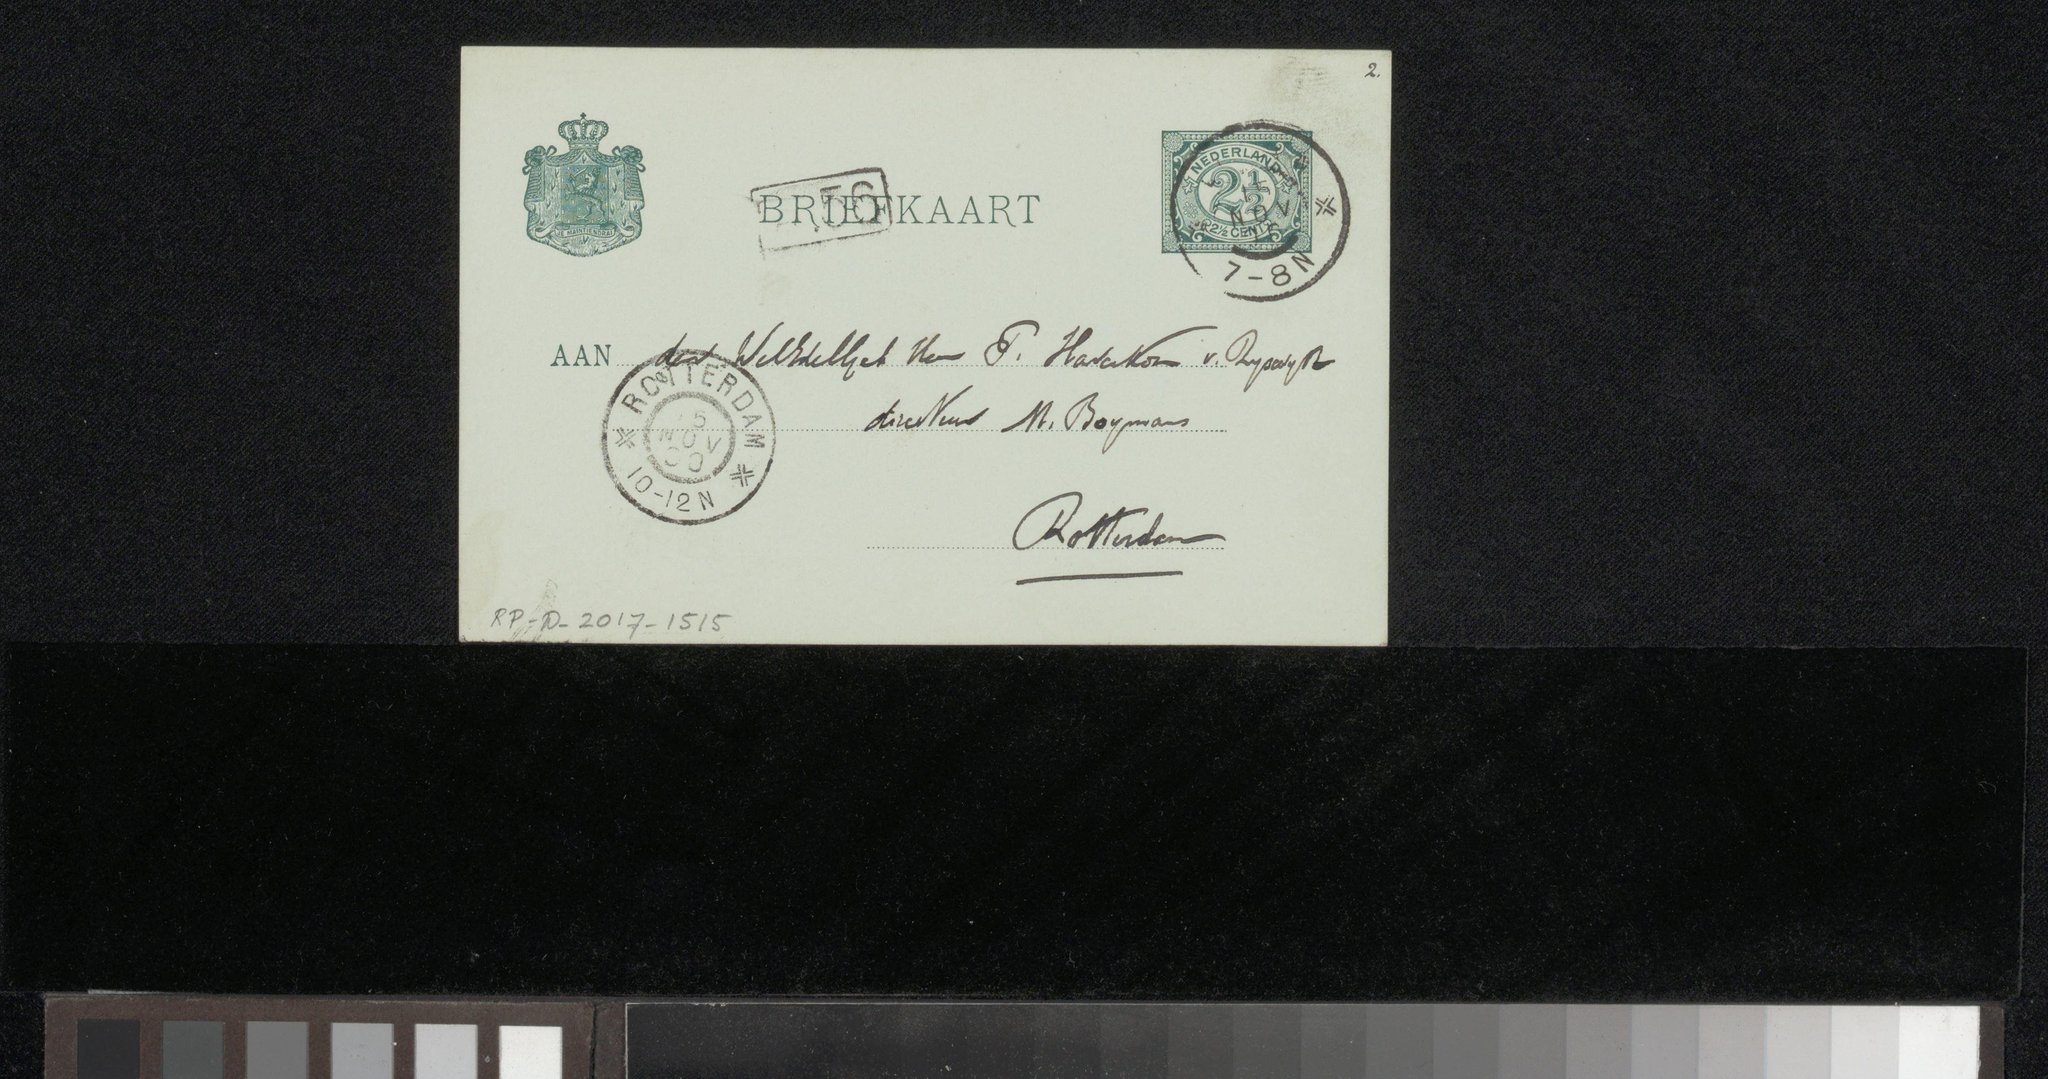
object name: postcard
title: Briefkaart aan Pieter Haverkorn van Rijsewijk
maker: ch.m. dozy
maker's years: 1852-1901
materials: cardboard, ink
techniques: pen, writing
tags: pieter haverkorn van rijsewijk, amsterdam, historical persons (portraits and scenes from the life)